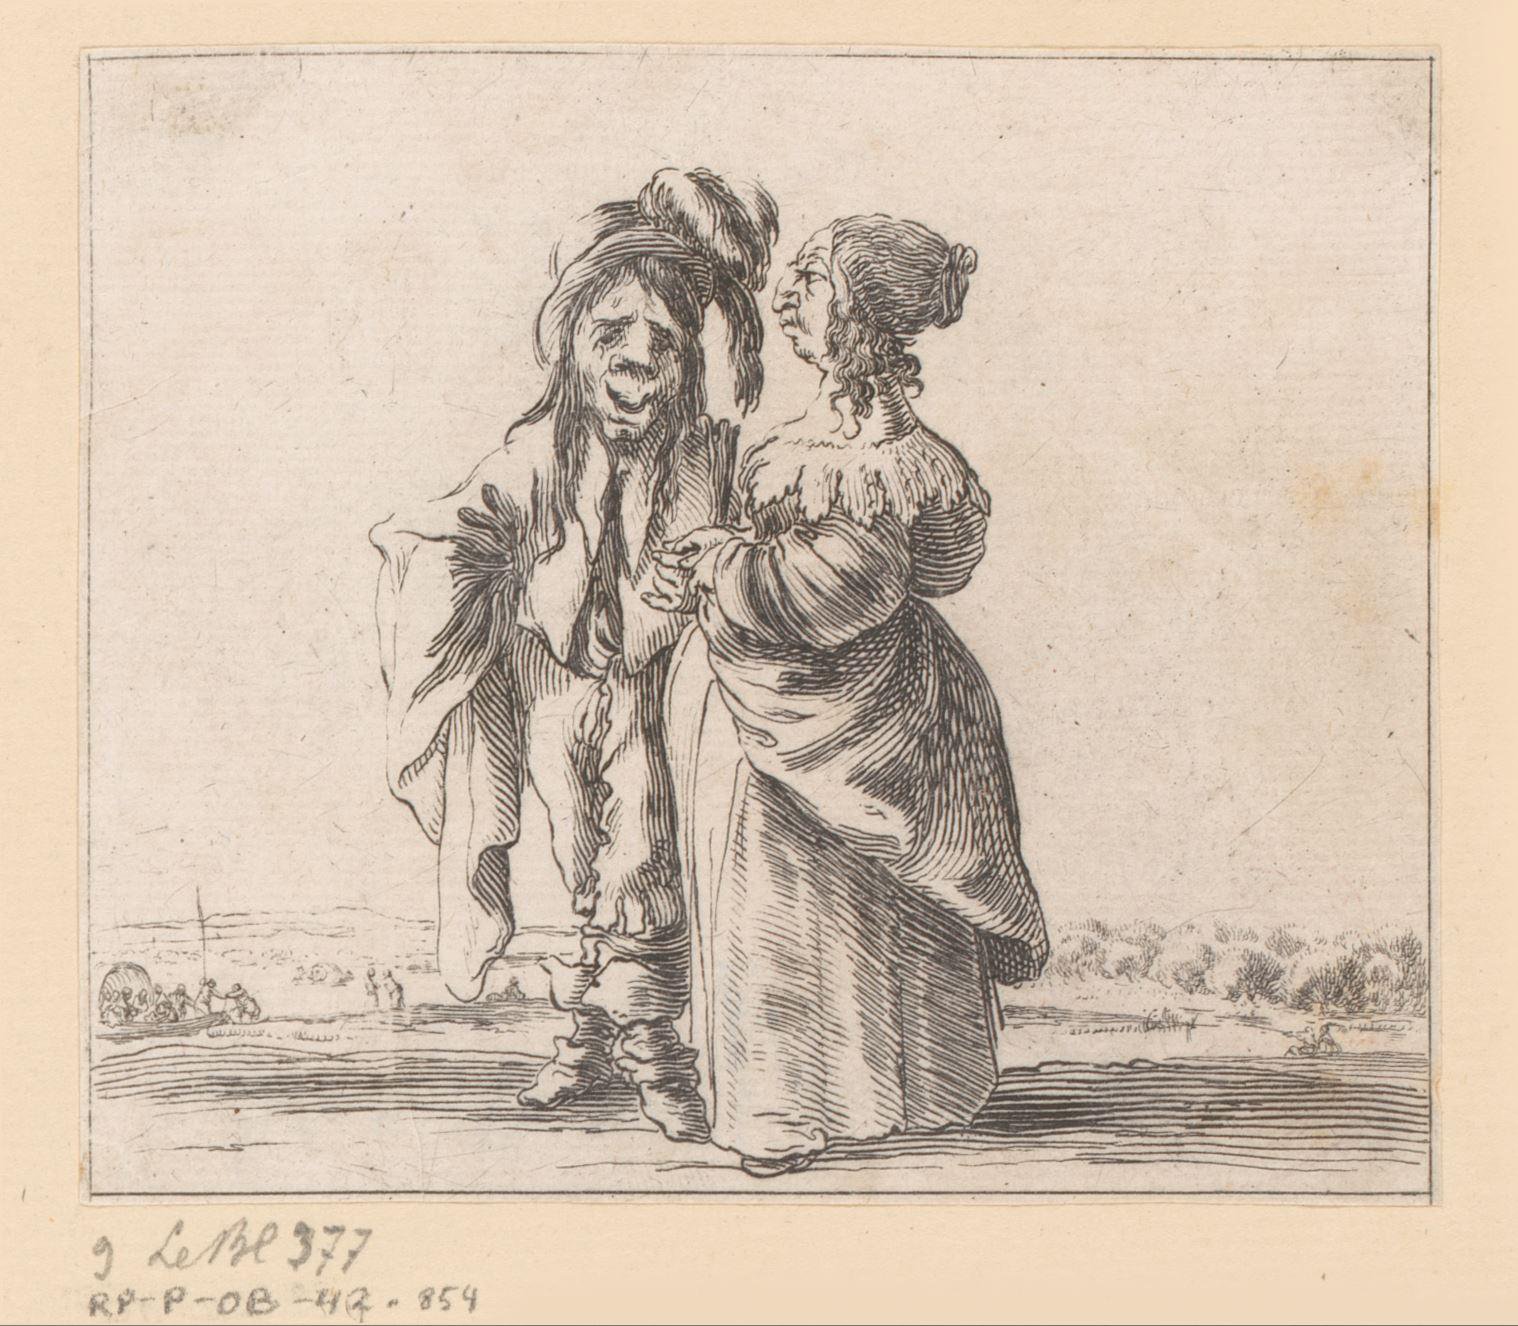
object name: print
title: Karikaturale voorstelling van een man en een vrouw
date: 1620-1687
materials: paper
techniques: engraving, etching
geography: france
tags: adult woman, caricatures (human types), adult man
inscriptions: collector's mark: Lugt 240